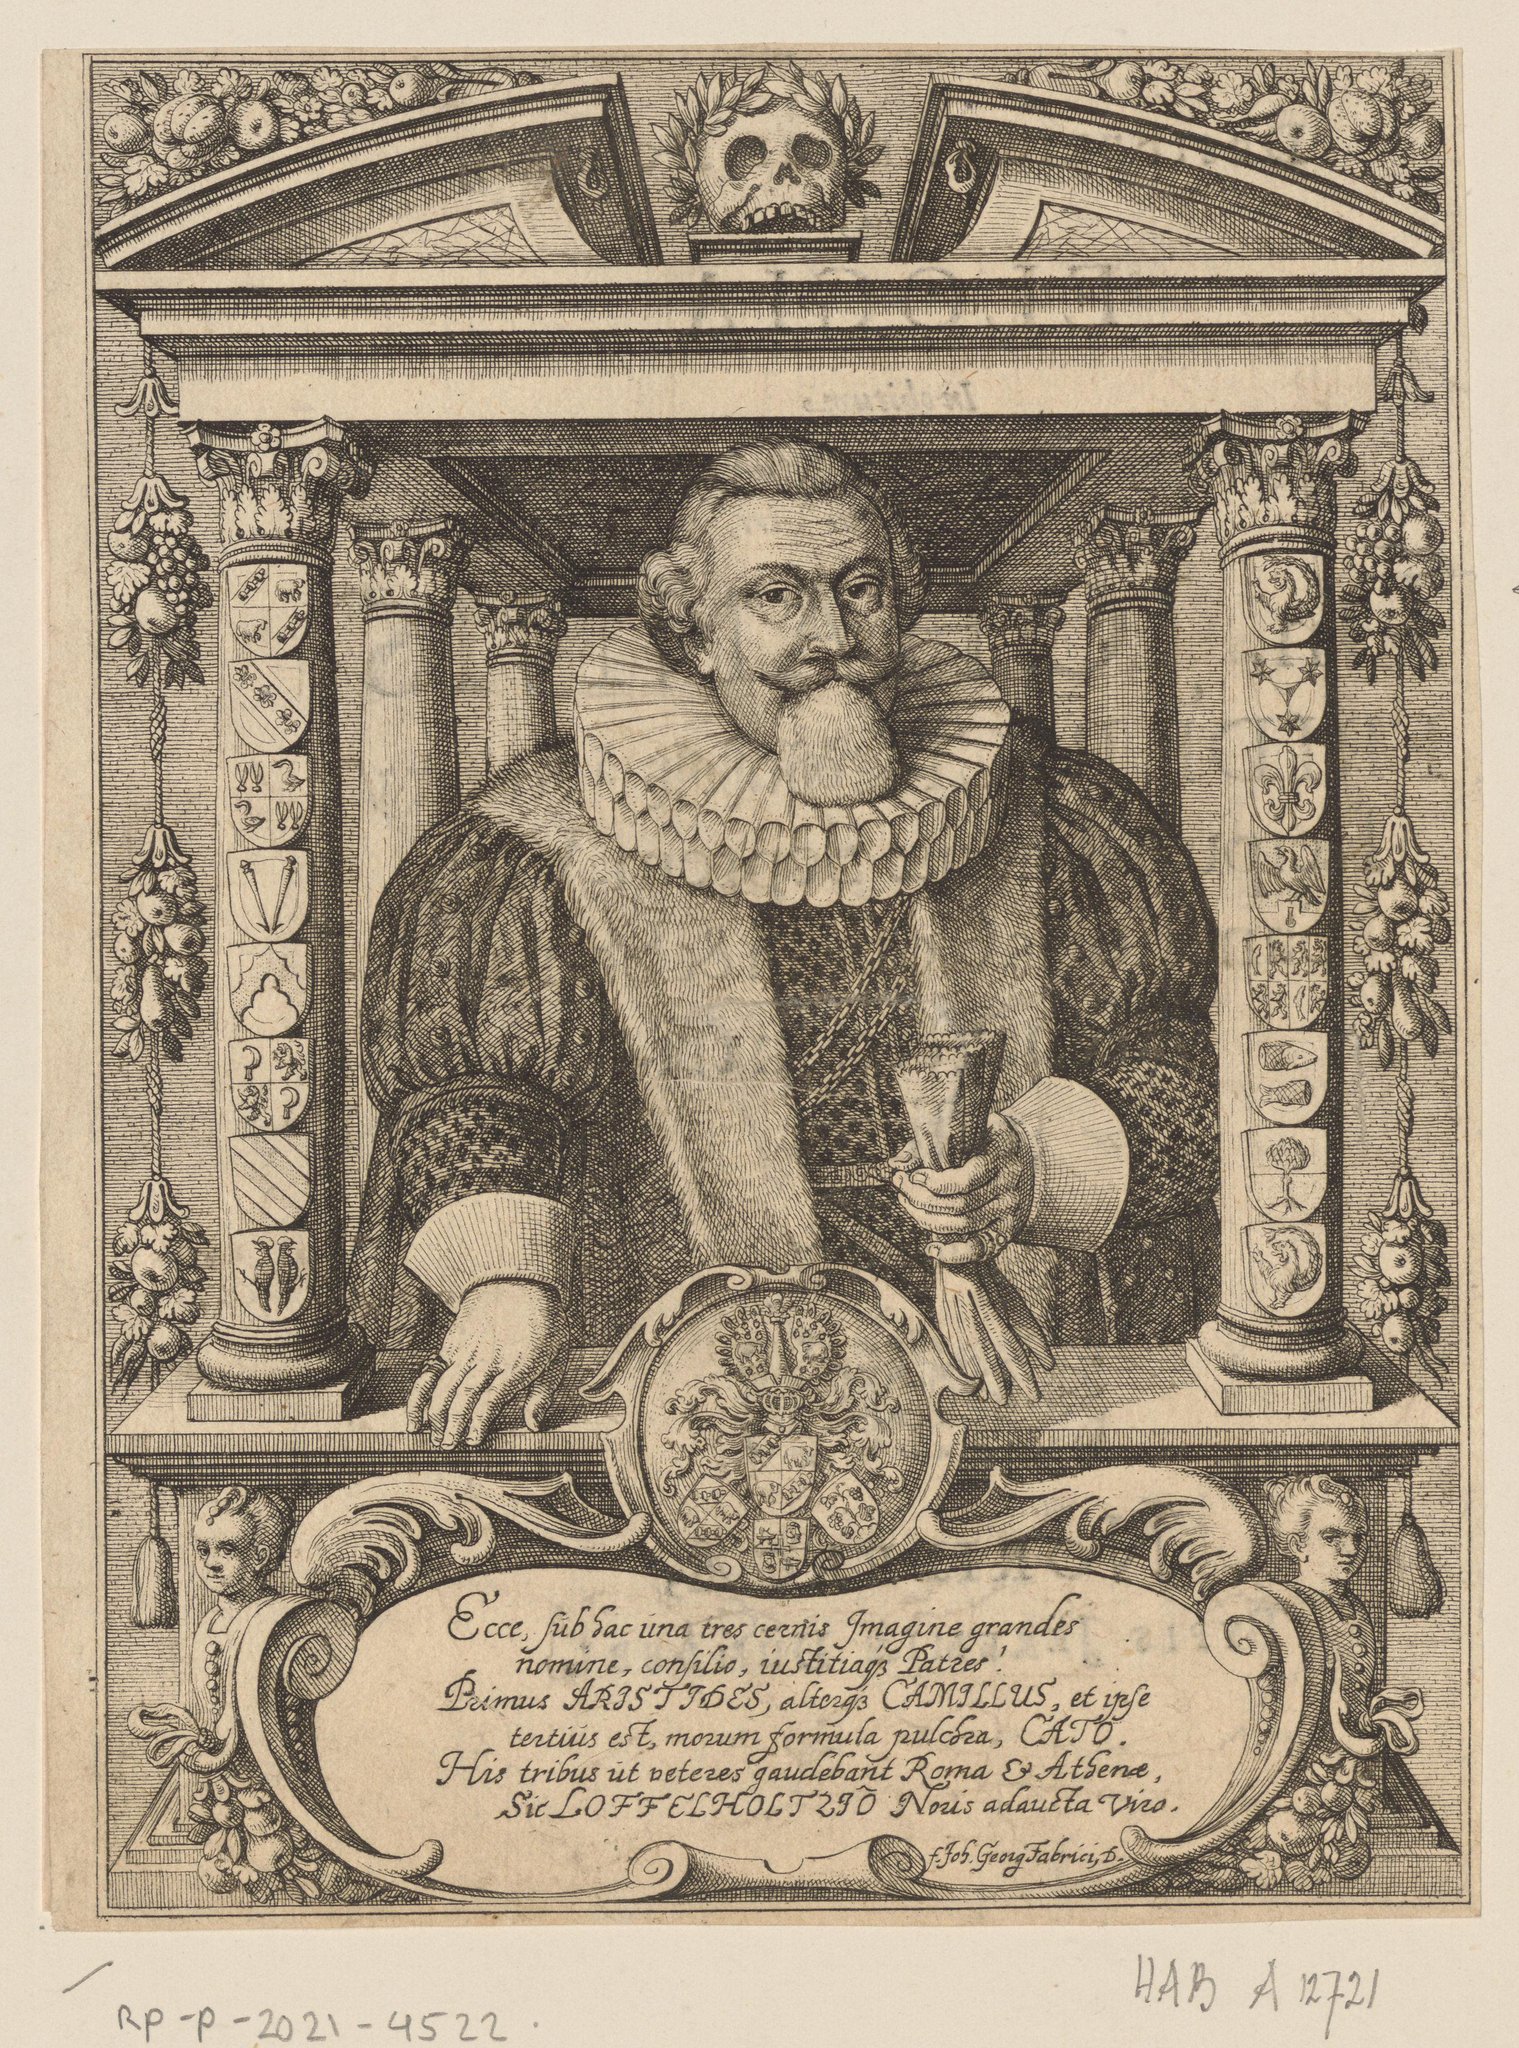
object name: book illustration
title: Portret van Johann Friedrich Löffelholz von Colberg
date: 1640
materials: paper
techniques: etching, letterpress printing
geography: nuremberg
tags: fruits and vegetables ~ ornament, column, pillar ~ architecture, gloves, mittens, etc., historical persons, skull as symbol of 'vanitas', ornament ~ cartouche, armorial bearing, heraldry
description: Verso is titelpagina van: Desiderium Reipub. Noricae, Sive Elogia (...). Neurenberg: Jeremias Dümler, [1640].